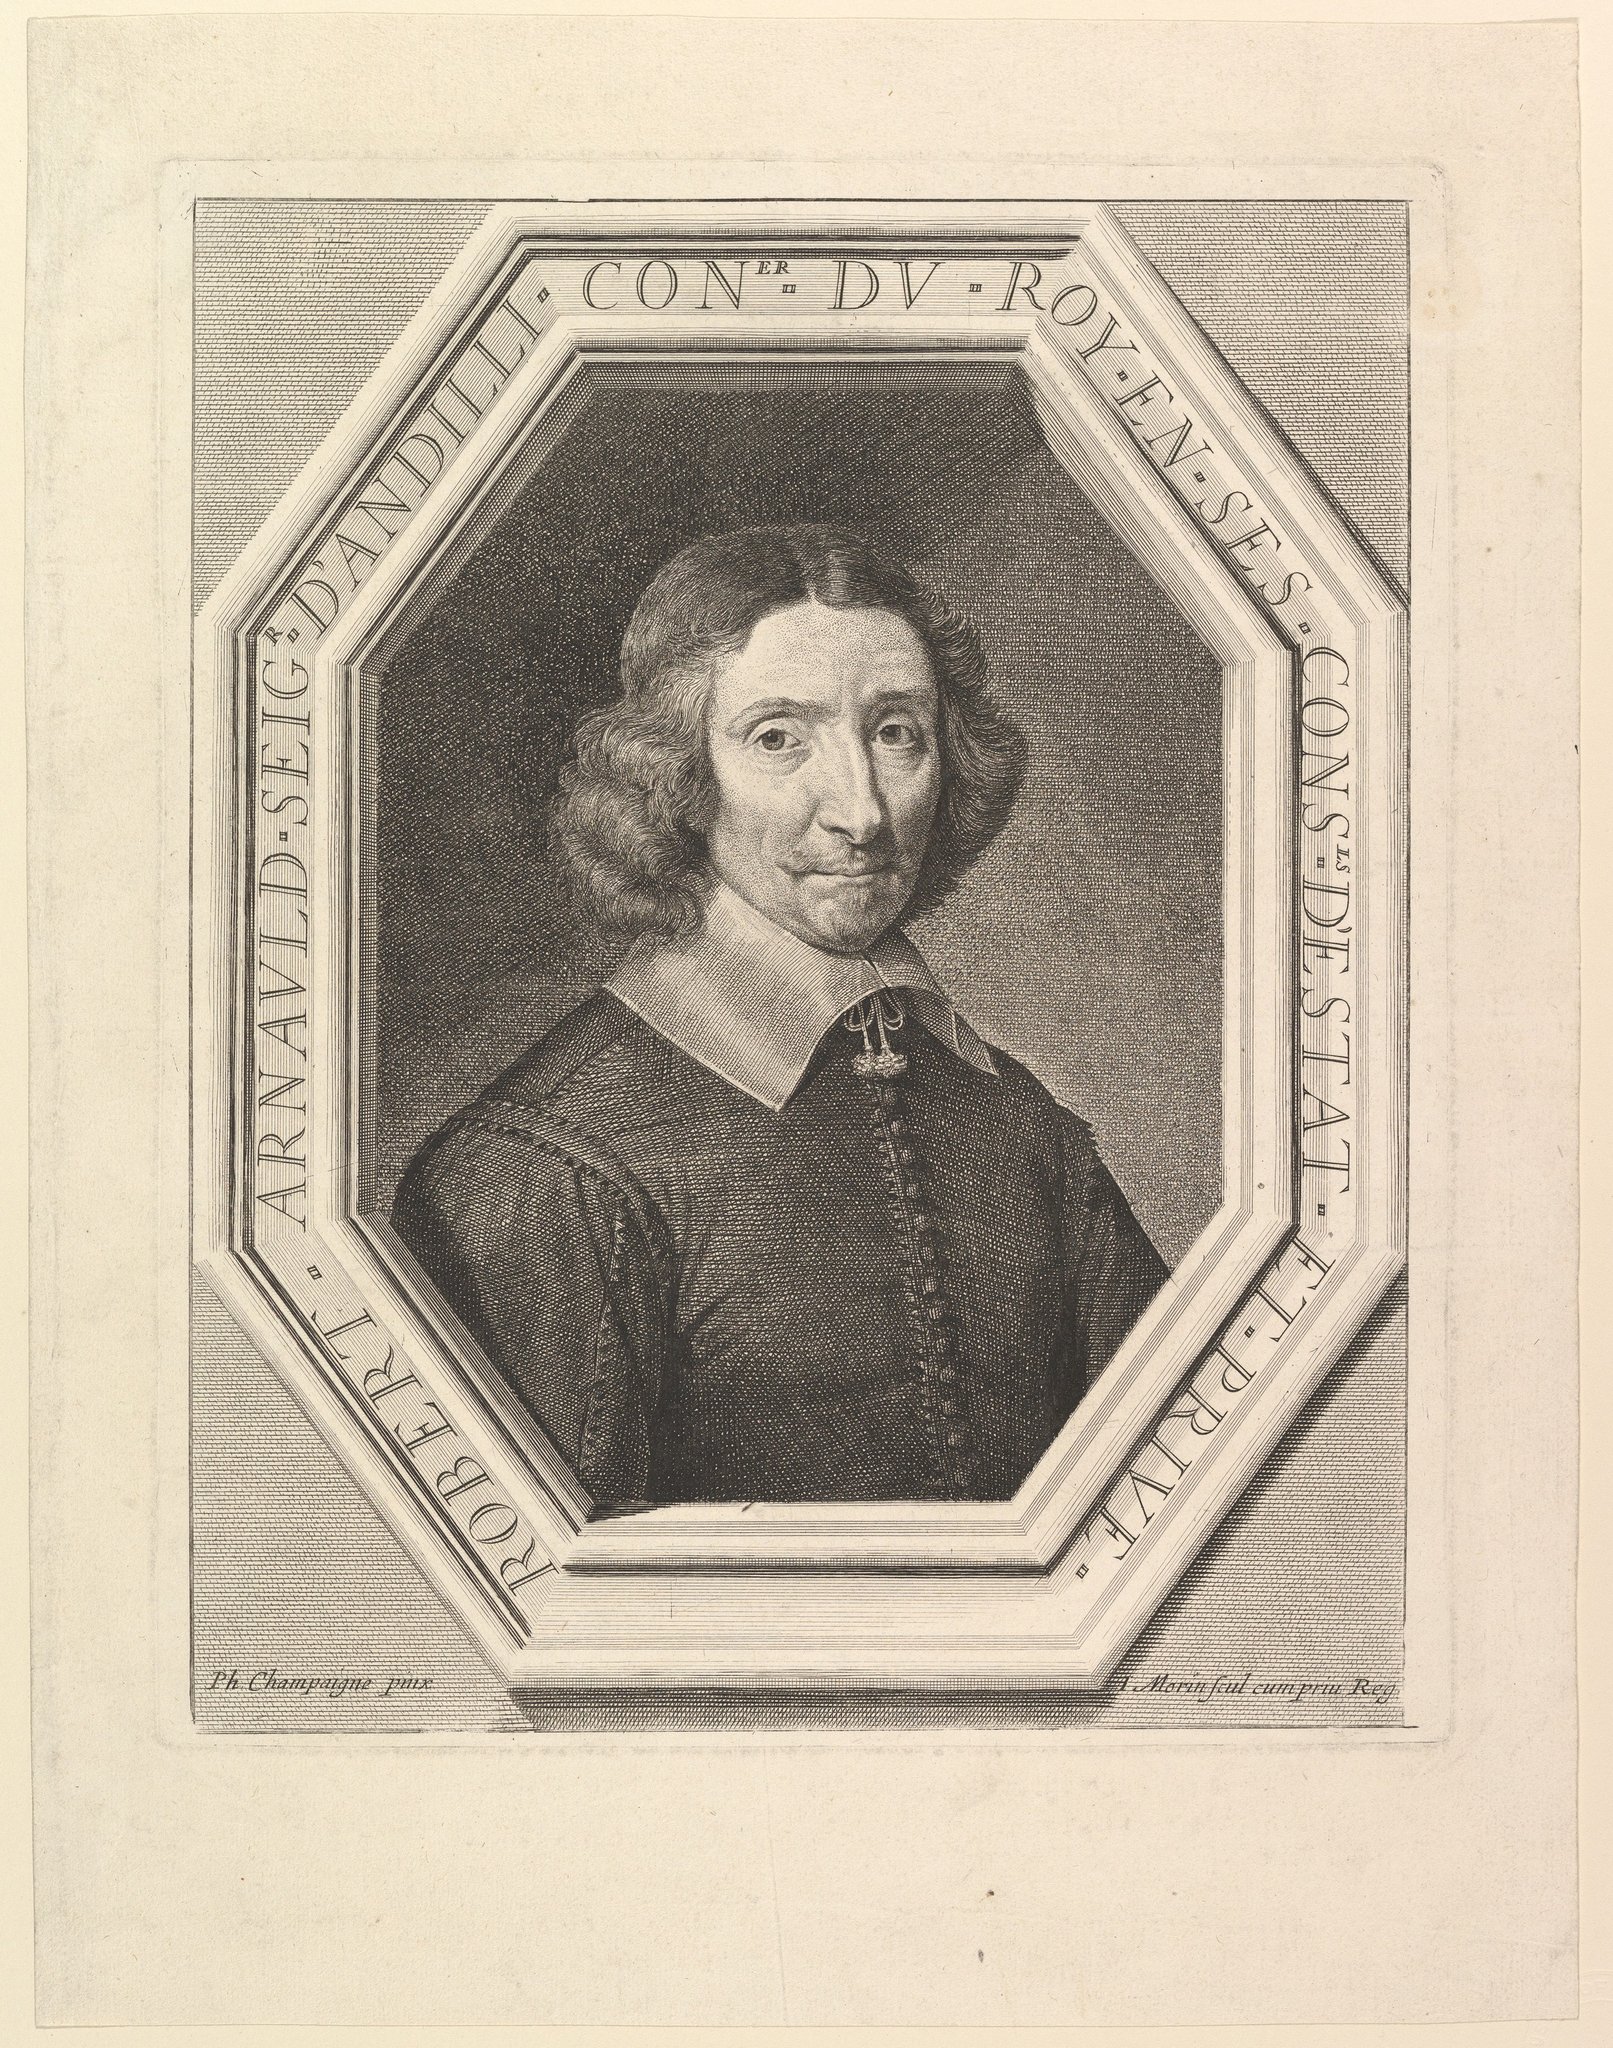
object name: print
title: Robert Arnauld d'Andilly, conseiller du roi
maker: jean morin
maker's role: artist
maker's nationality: french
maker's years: 1605-1650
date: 1605-1650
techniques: etching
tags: men,portraits